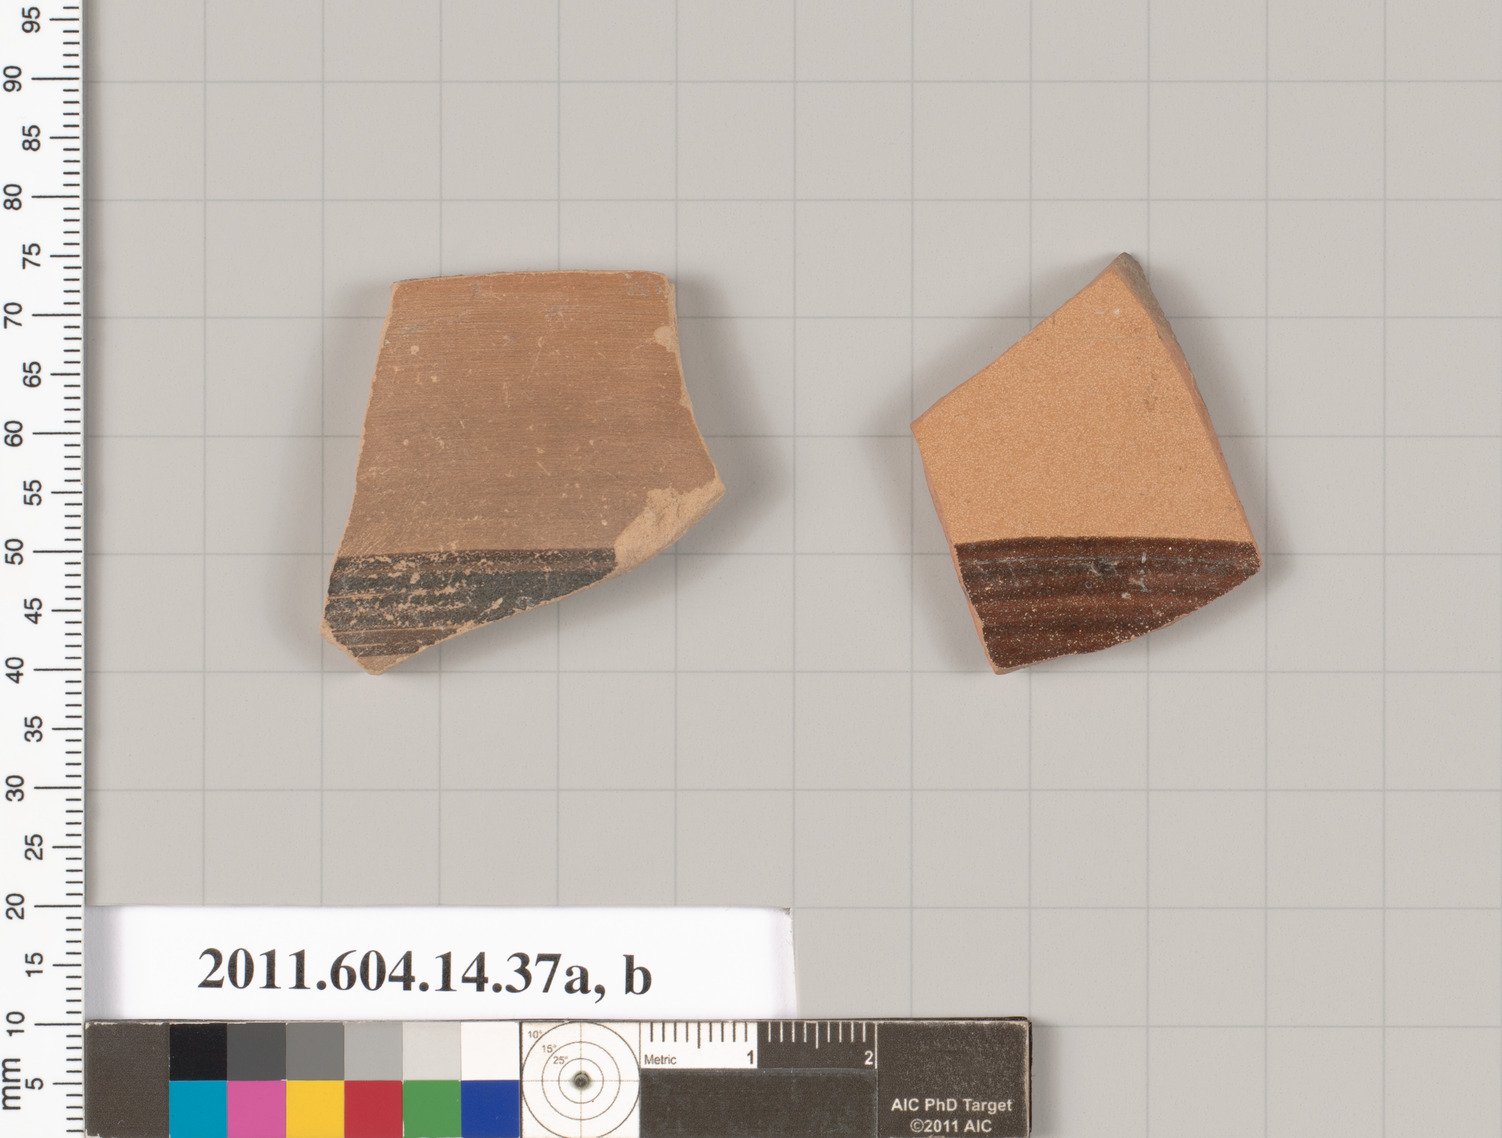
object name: undetermined closed shape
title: Terracotta fragments of closed shapes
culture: unknown fabric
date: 600-401 BCE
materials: terracotta